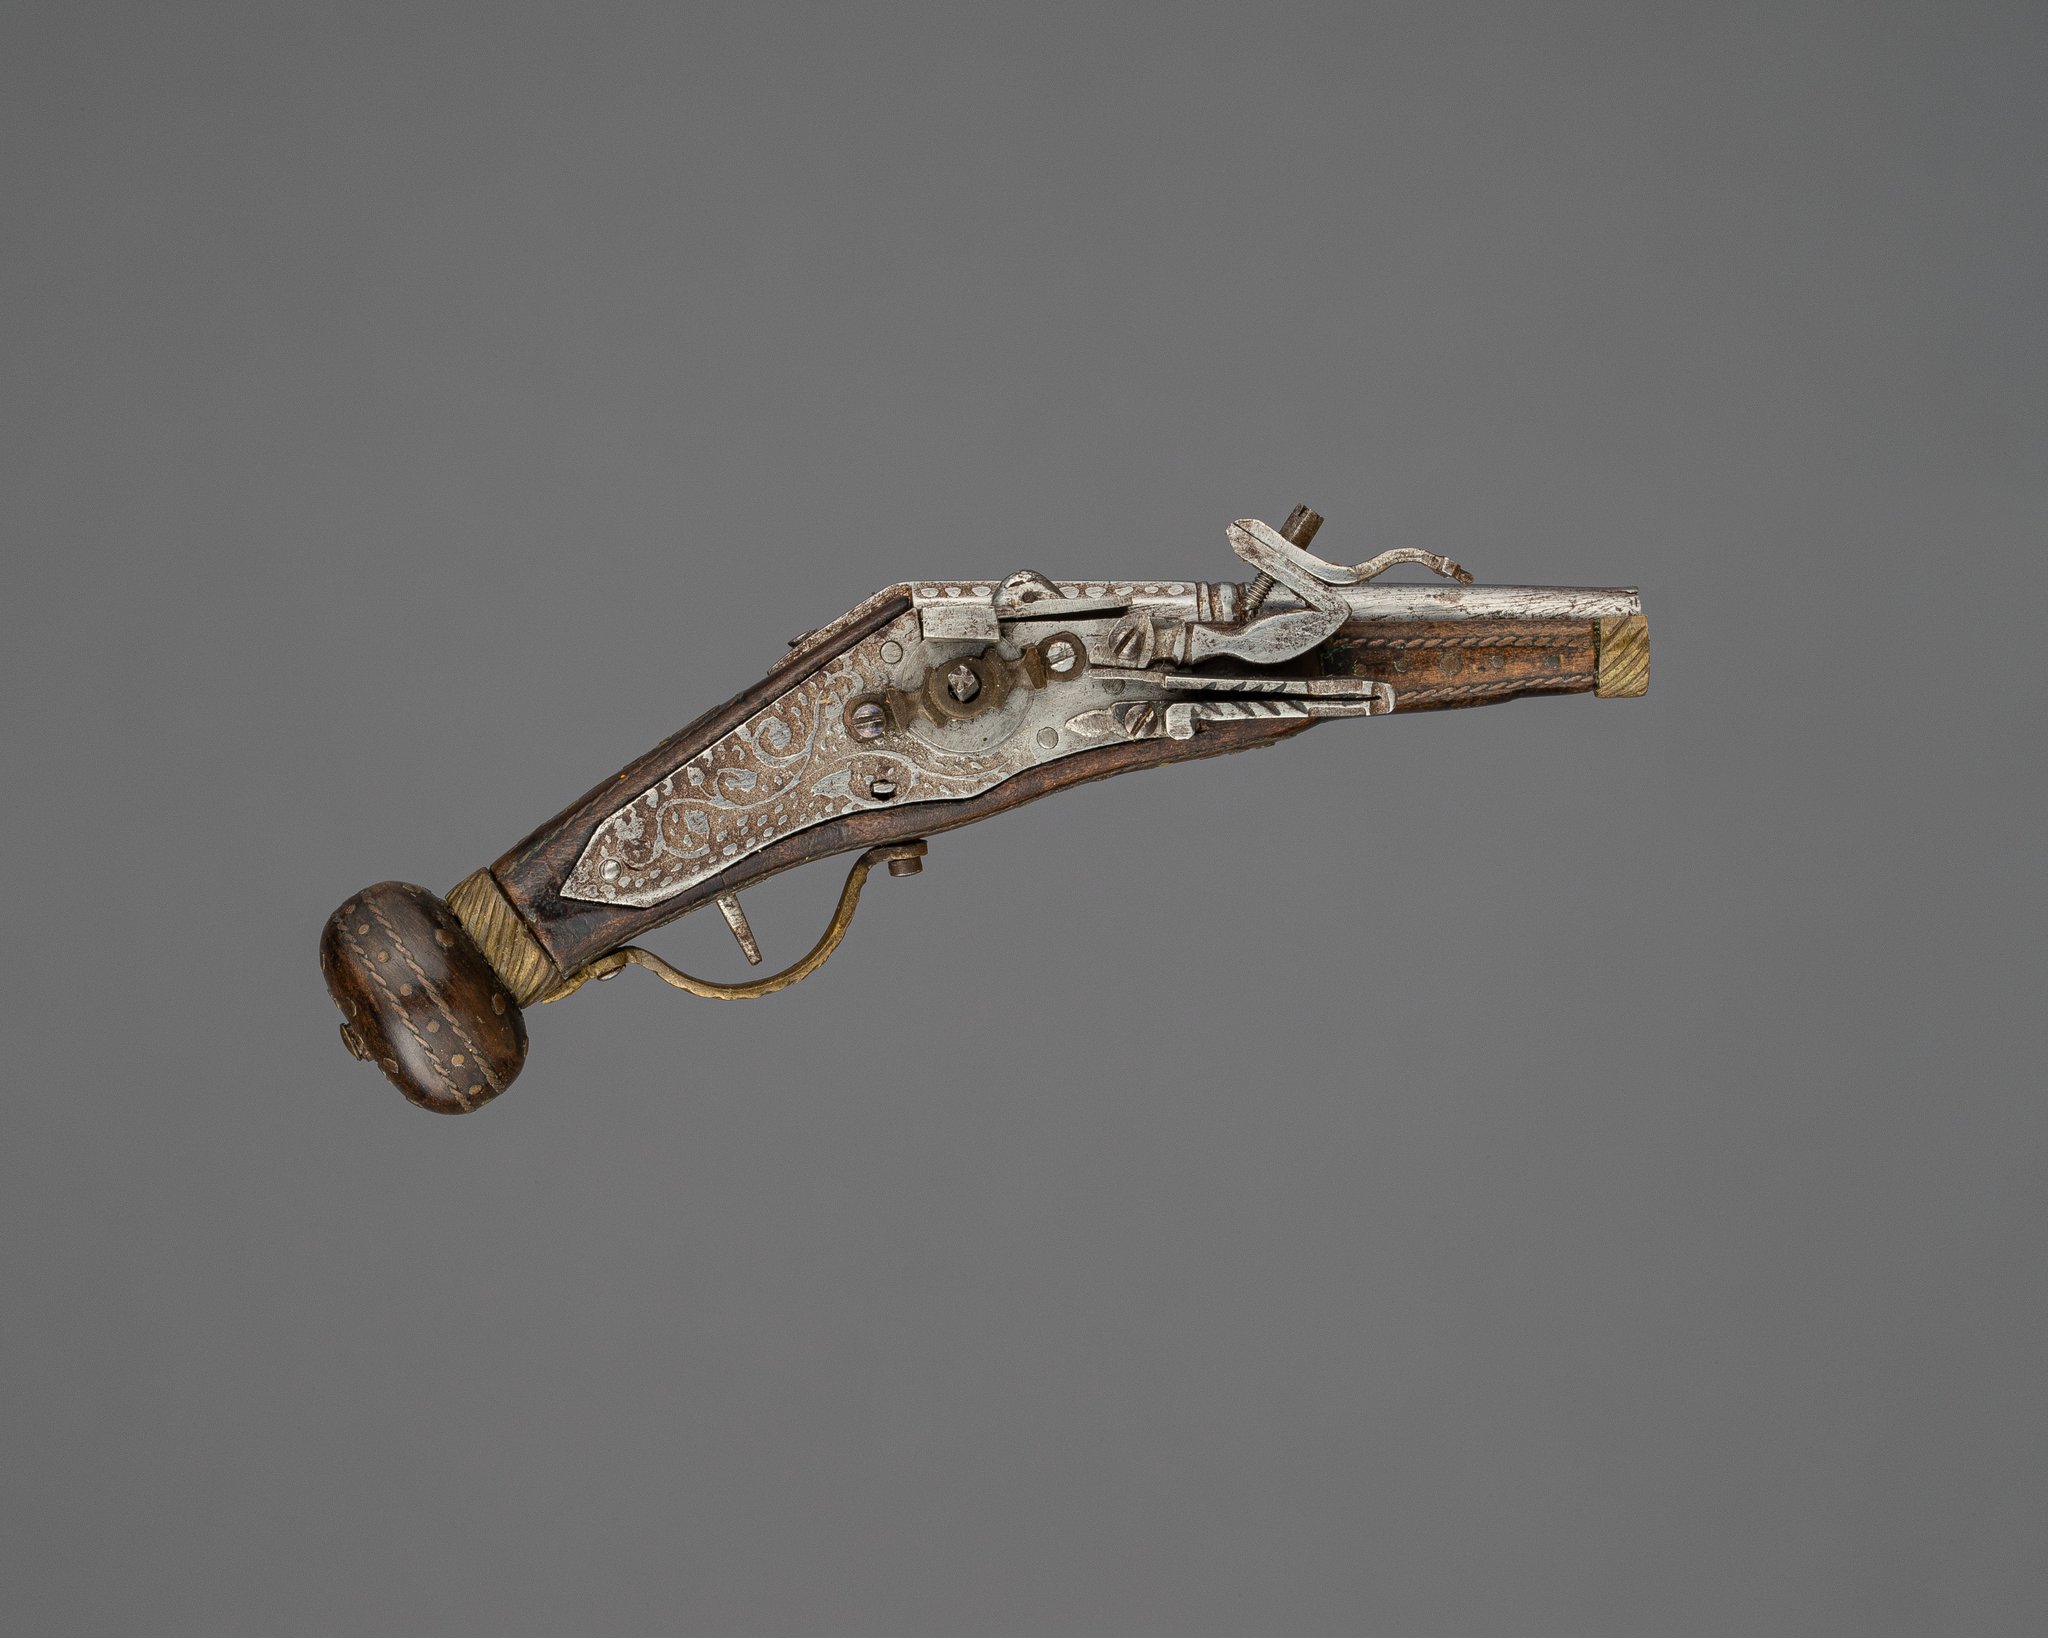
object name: pair of wheellock pistol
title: Model of Pair of Wheellock Pistols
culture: german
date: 1550-1600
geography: germany